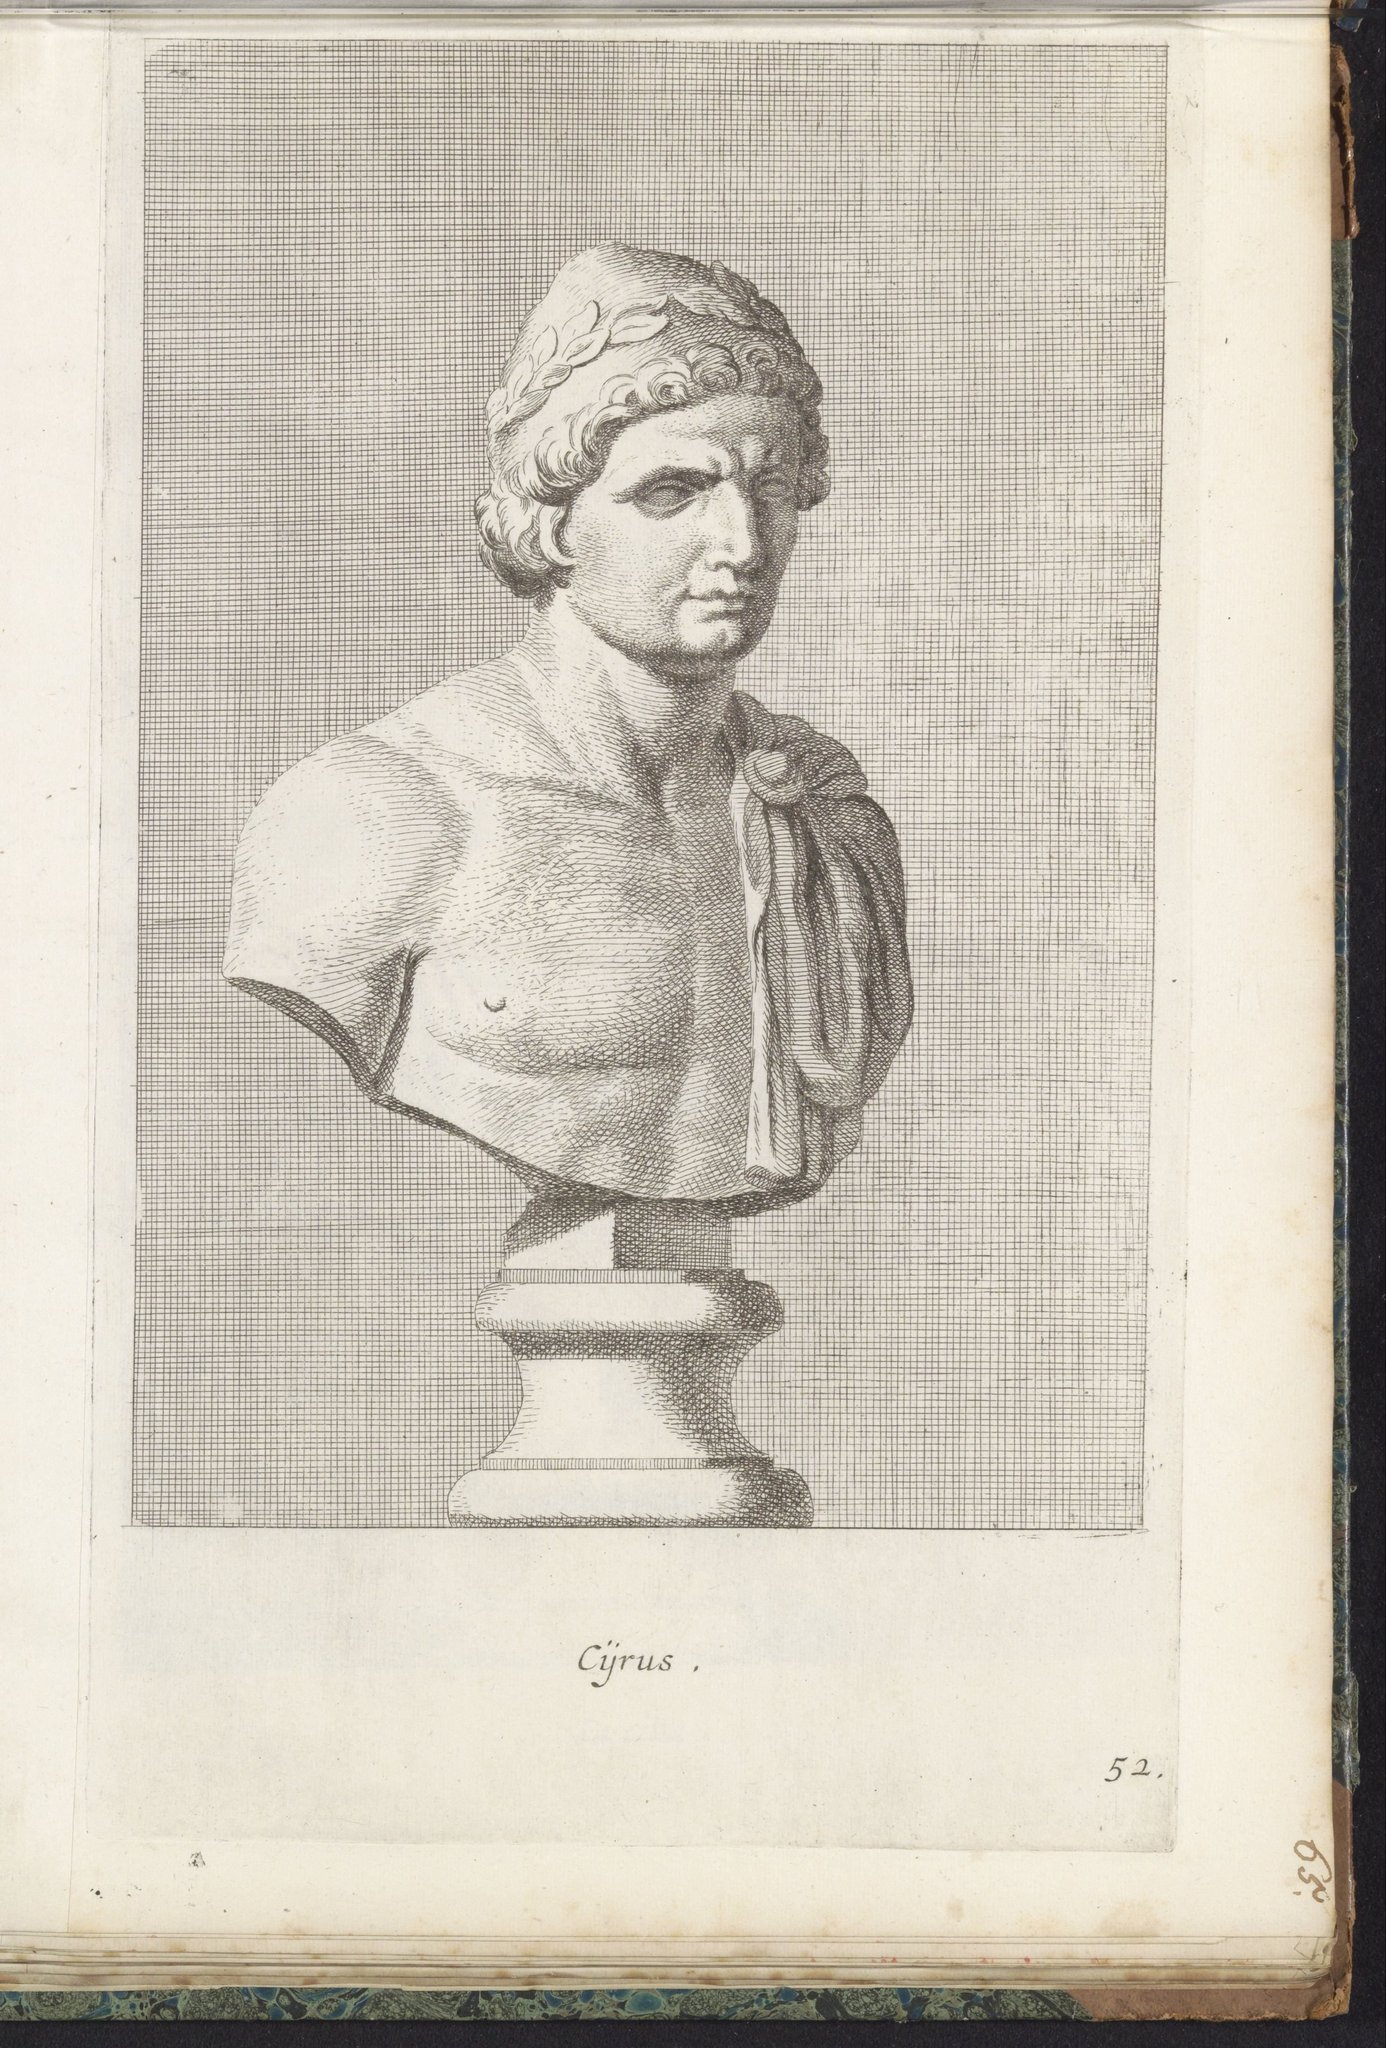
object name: print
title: Cijrus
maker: hubert quellinus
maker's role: print maker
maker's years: 1619-1687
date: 1646-1670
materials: paper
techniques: engraving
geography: antwerp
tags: piece of sculpture, reproduction of a piece of sculpture, male persons from classical history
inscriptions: number: ‘65’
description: Klassieke buste van een man met een Frygische muts op zijn hoofd. De prent maakt deel uit van een album met een serie prenten naar de sculpturen in de verzameling van Gerard Reynst.